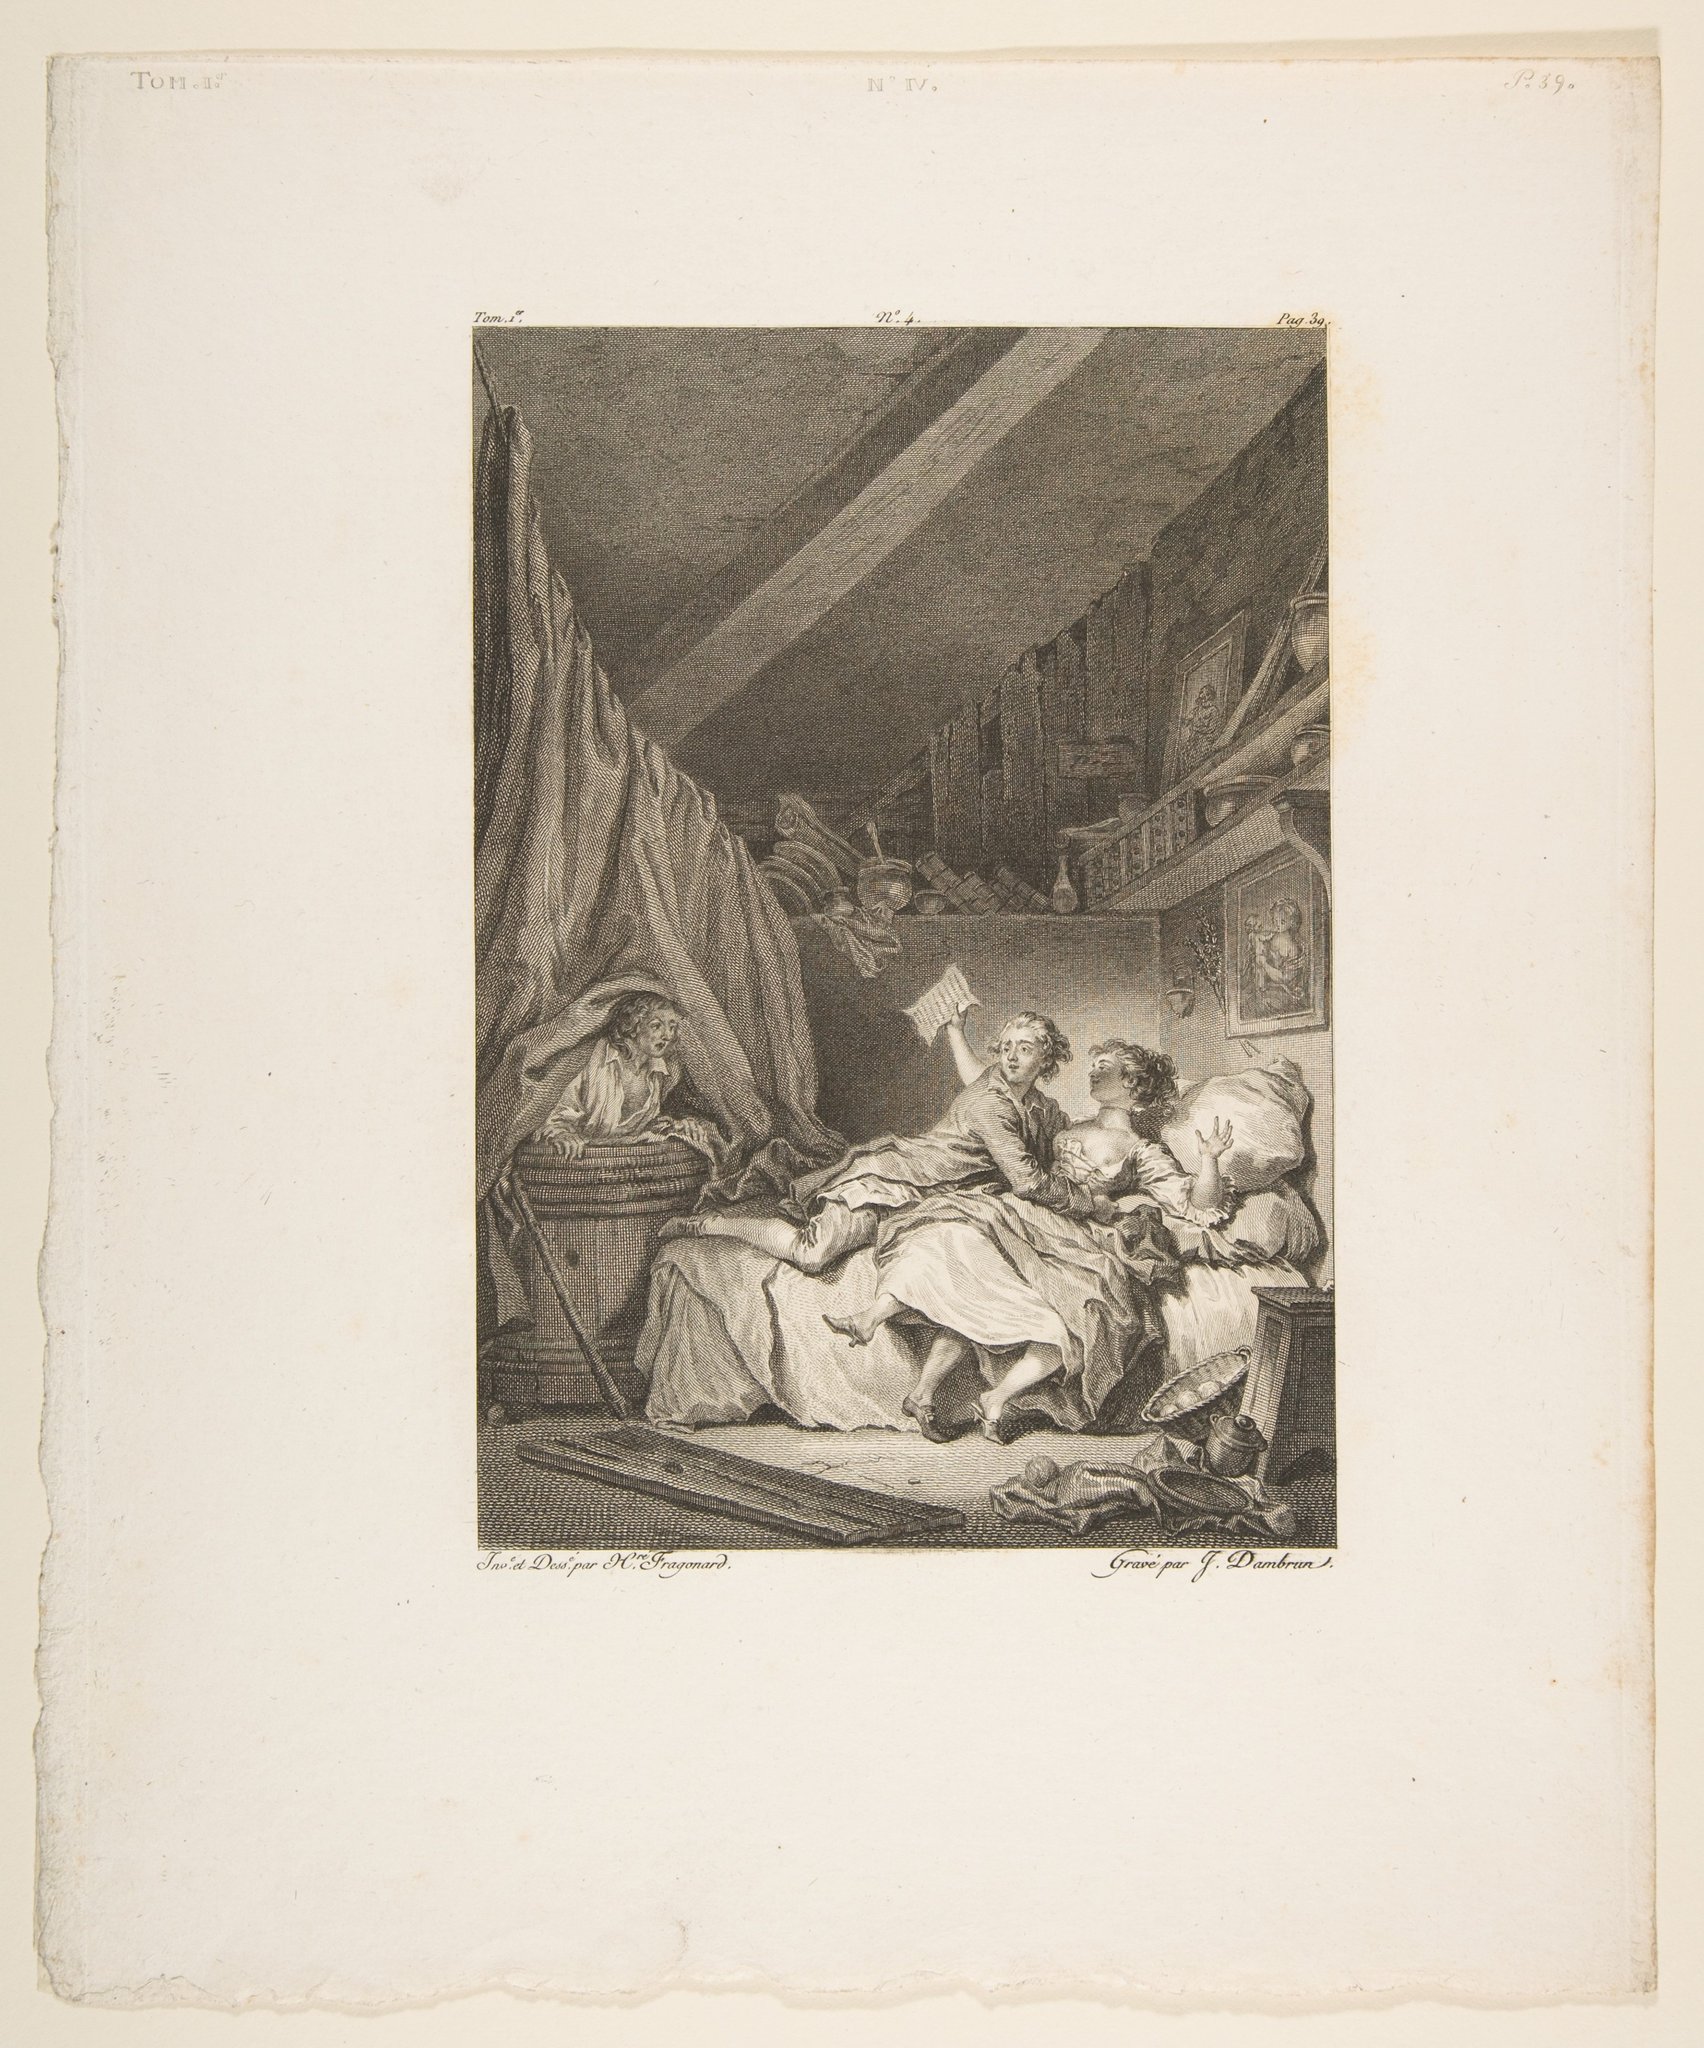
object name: print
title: Contes et nouvelles en vers: Le Savetier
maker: jean de la fontaine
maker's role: author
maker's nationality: french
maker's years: 1621-1695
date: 1795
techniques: etching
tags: men,women